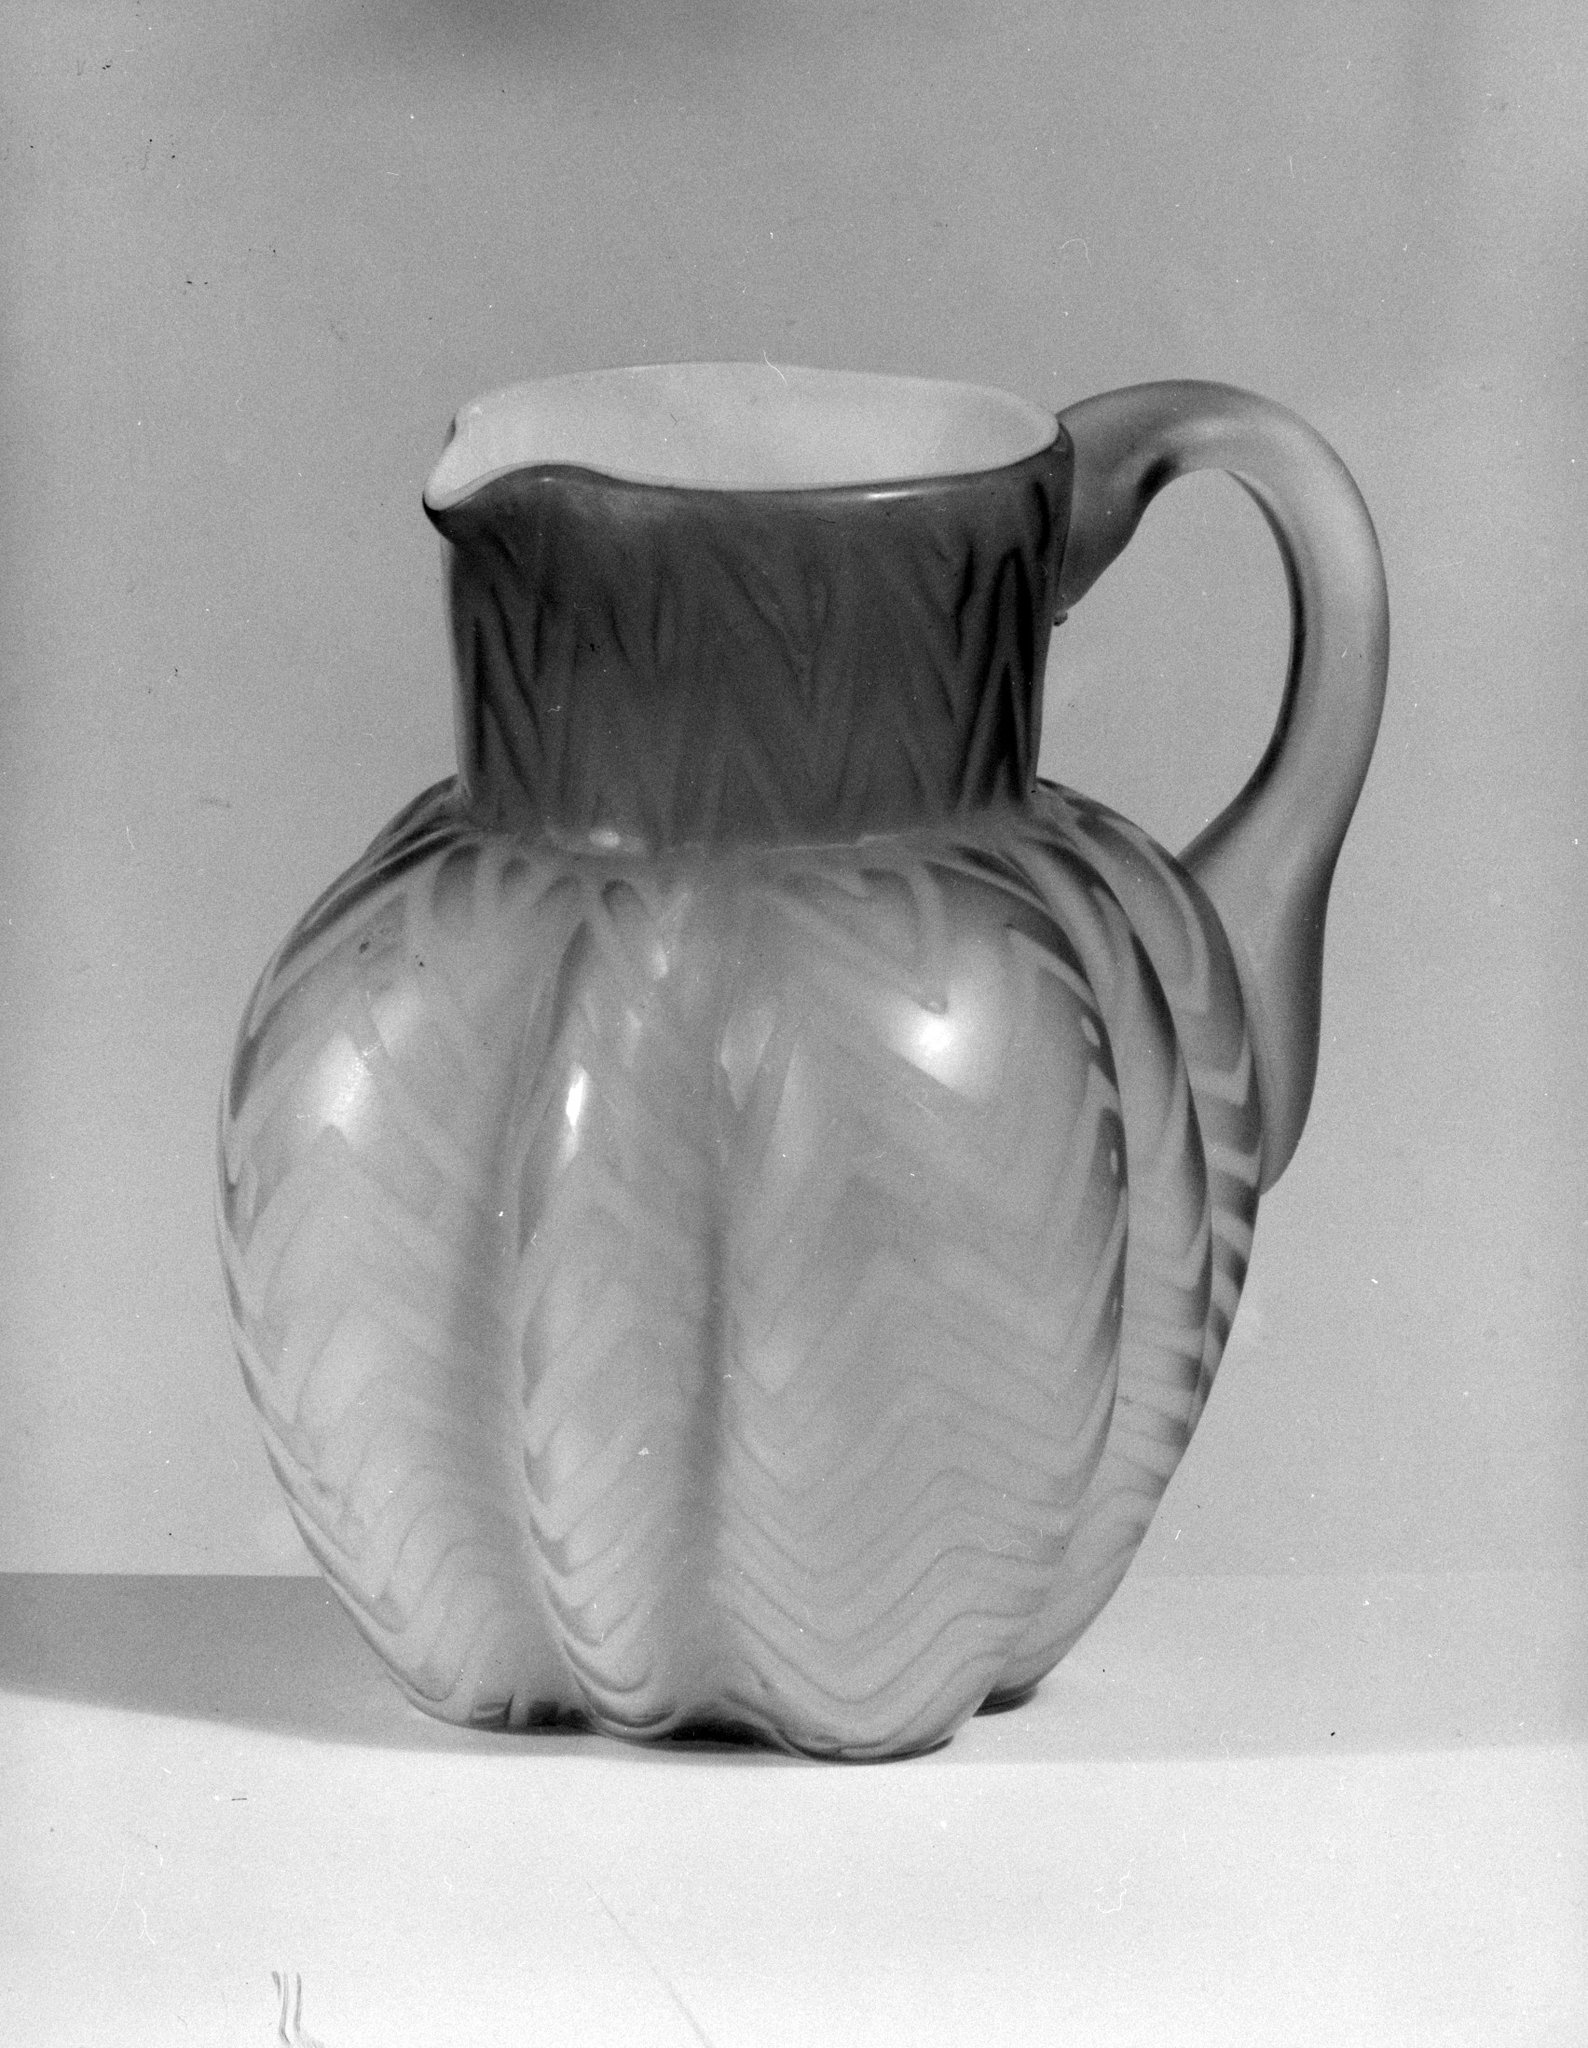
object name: pitcher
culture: american or british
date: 1885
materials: glass, textile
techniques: glassblowing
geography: england